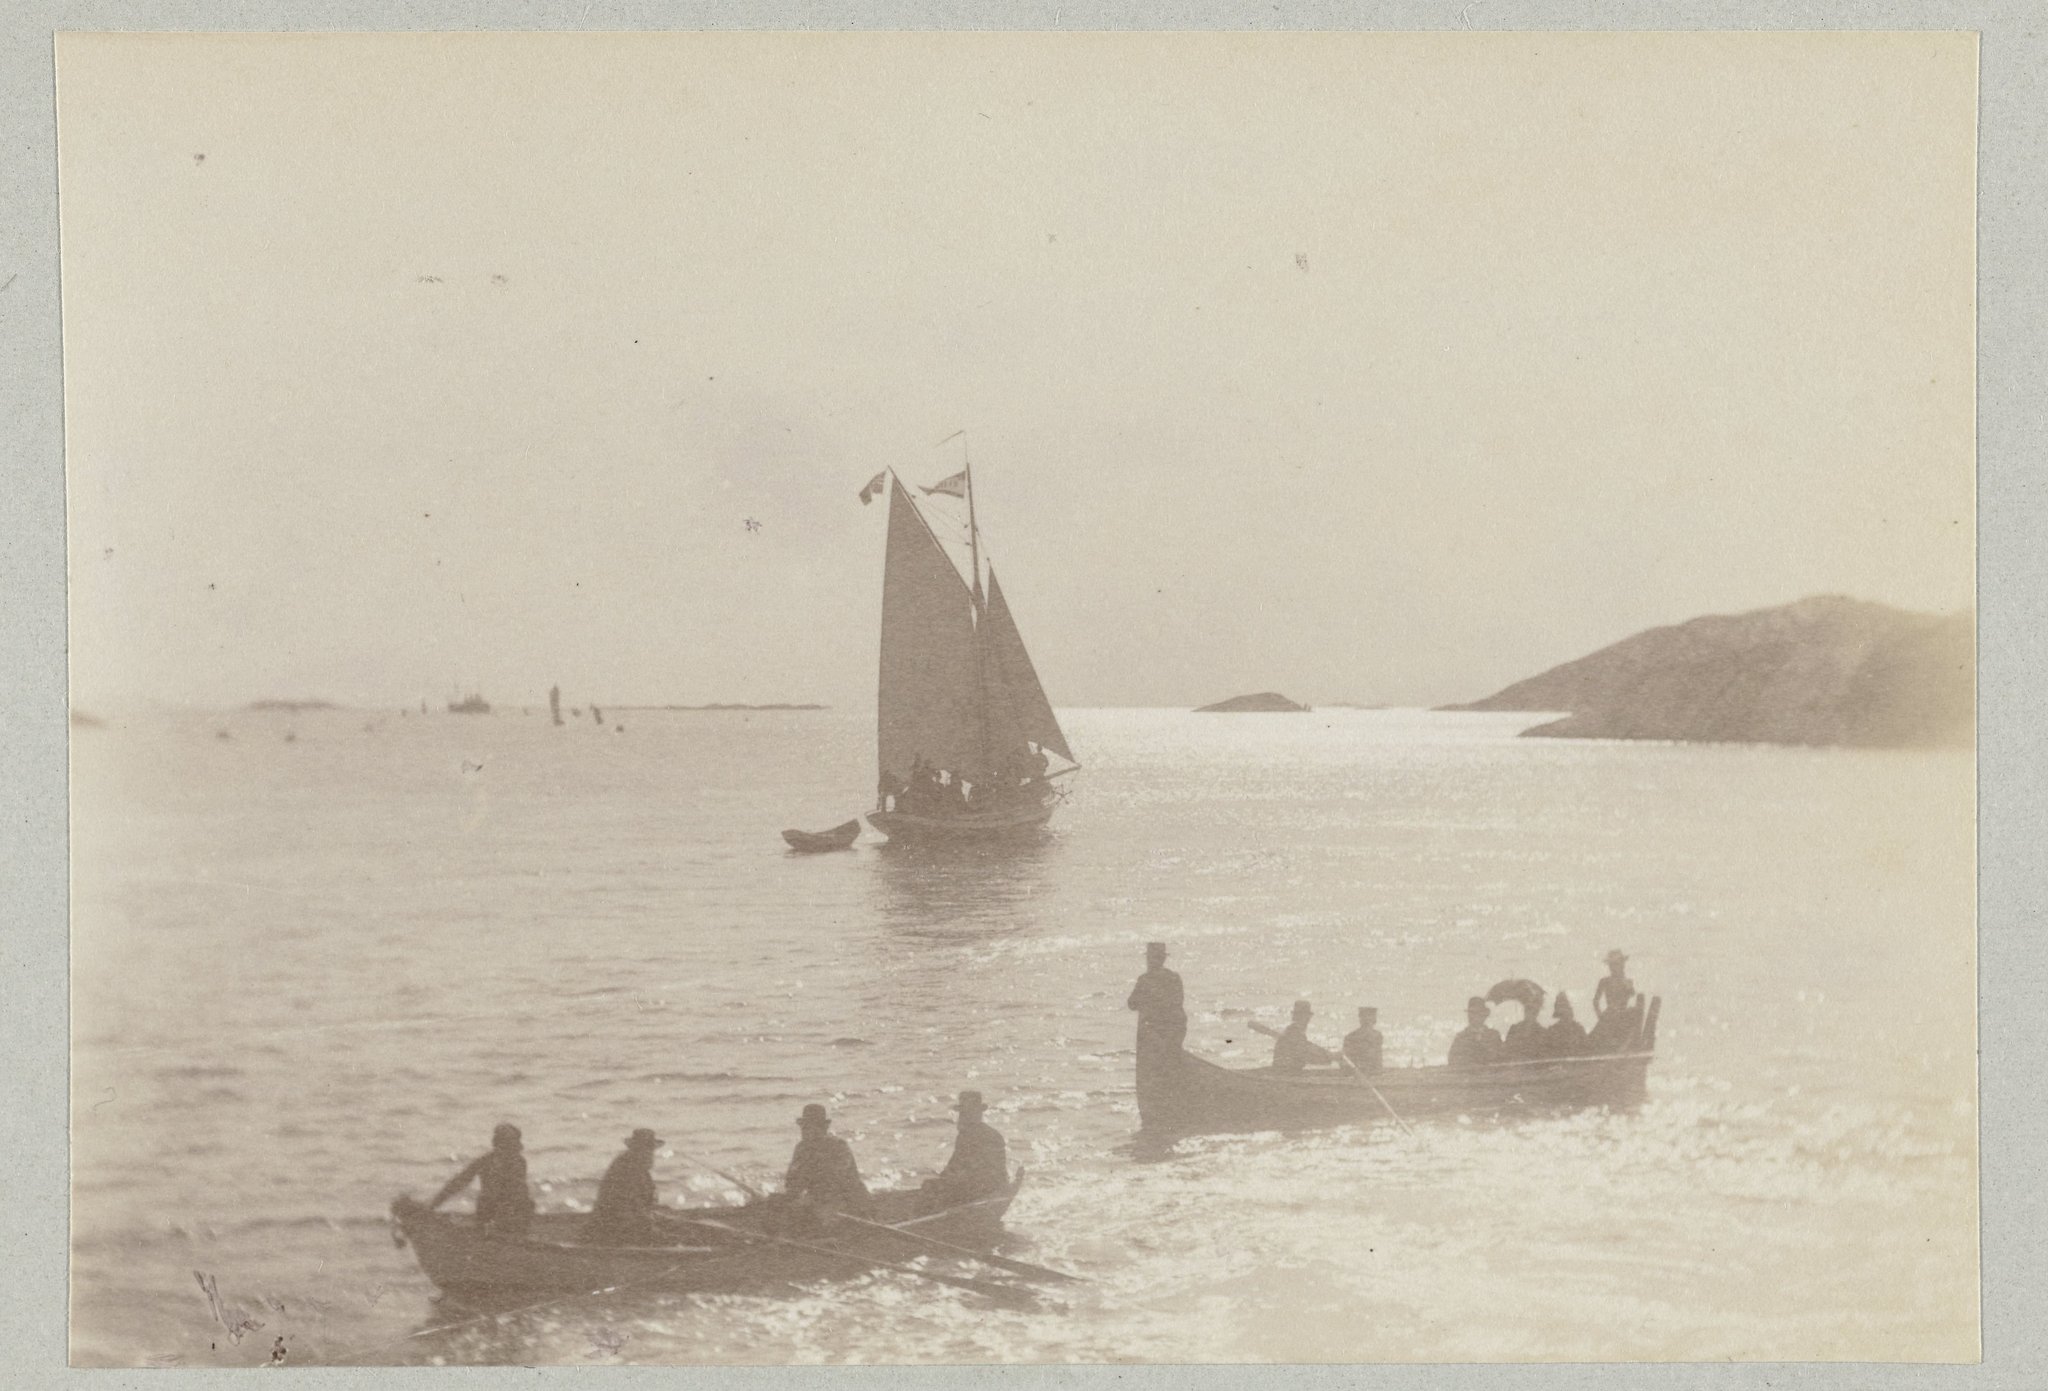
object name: photograph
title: Gezin voor hun houten woning met dakbegroeiing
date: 1807-1889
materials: cardboard, paper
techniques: albumen print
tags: wilhelm ii (keizer van duitsland), norway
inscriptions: number: ‘32’